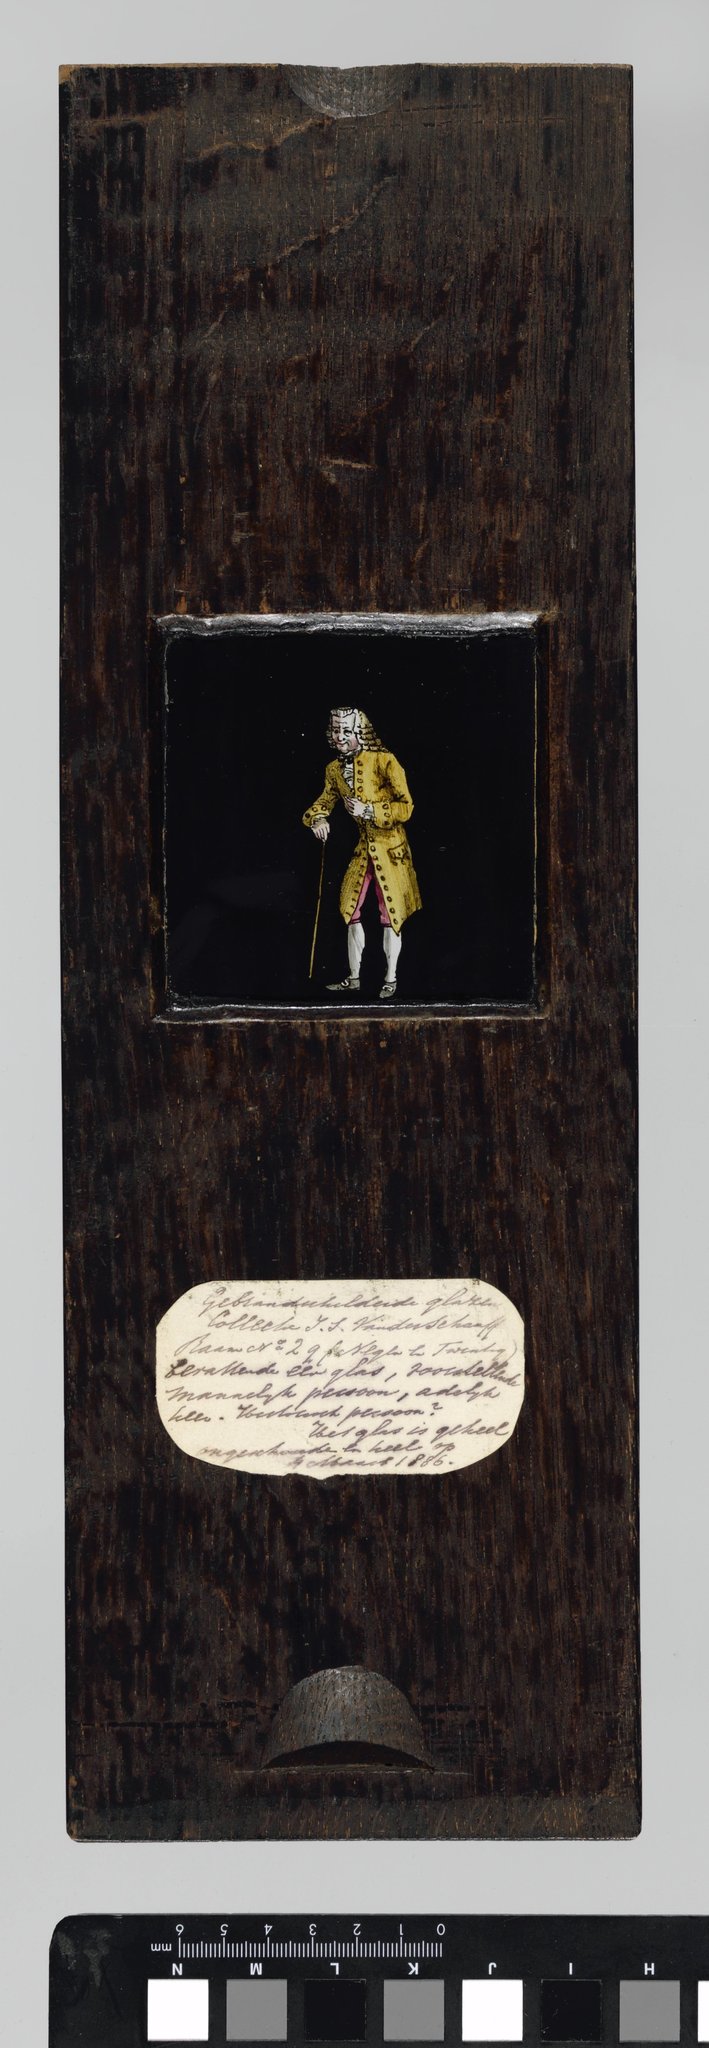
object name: lantern slide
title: Heer met stok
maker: Anonymous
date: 1790-1830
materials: glass, wood, oil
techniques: painted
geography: france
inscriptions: label: ‘'Gebrandschilderde glazen. Collectie J. I. Van der Schaaff Baarn. Nr. 29 (negen en twintig) bevattende één glas, voorstellende een mannelijk persoon, adellijke heer, historisch persoon? Het glas is geheel ongeschonden en heel op 4 maart 1886.'’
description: Vierkante glasplaat in houten vatting. Een heer in gele kleren, leunend op een stok, ten voeten uit. De achtergrond is zwart.